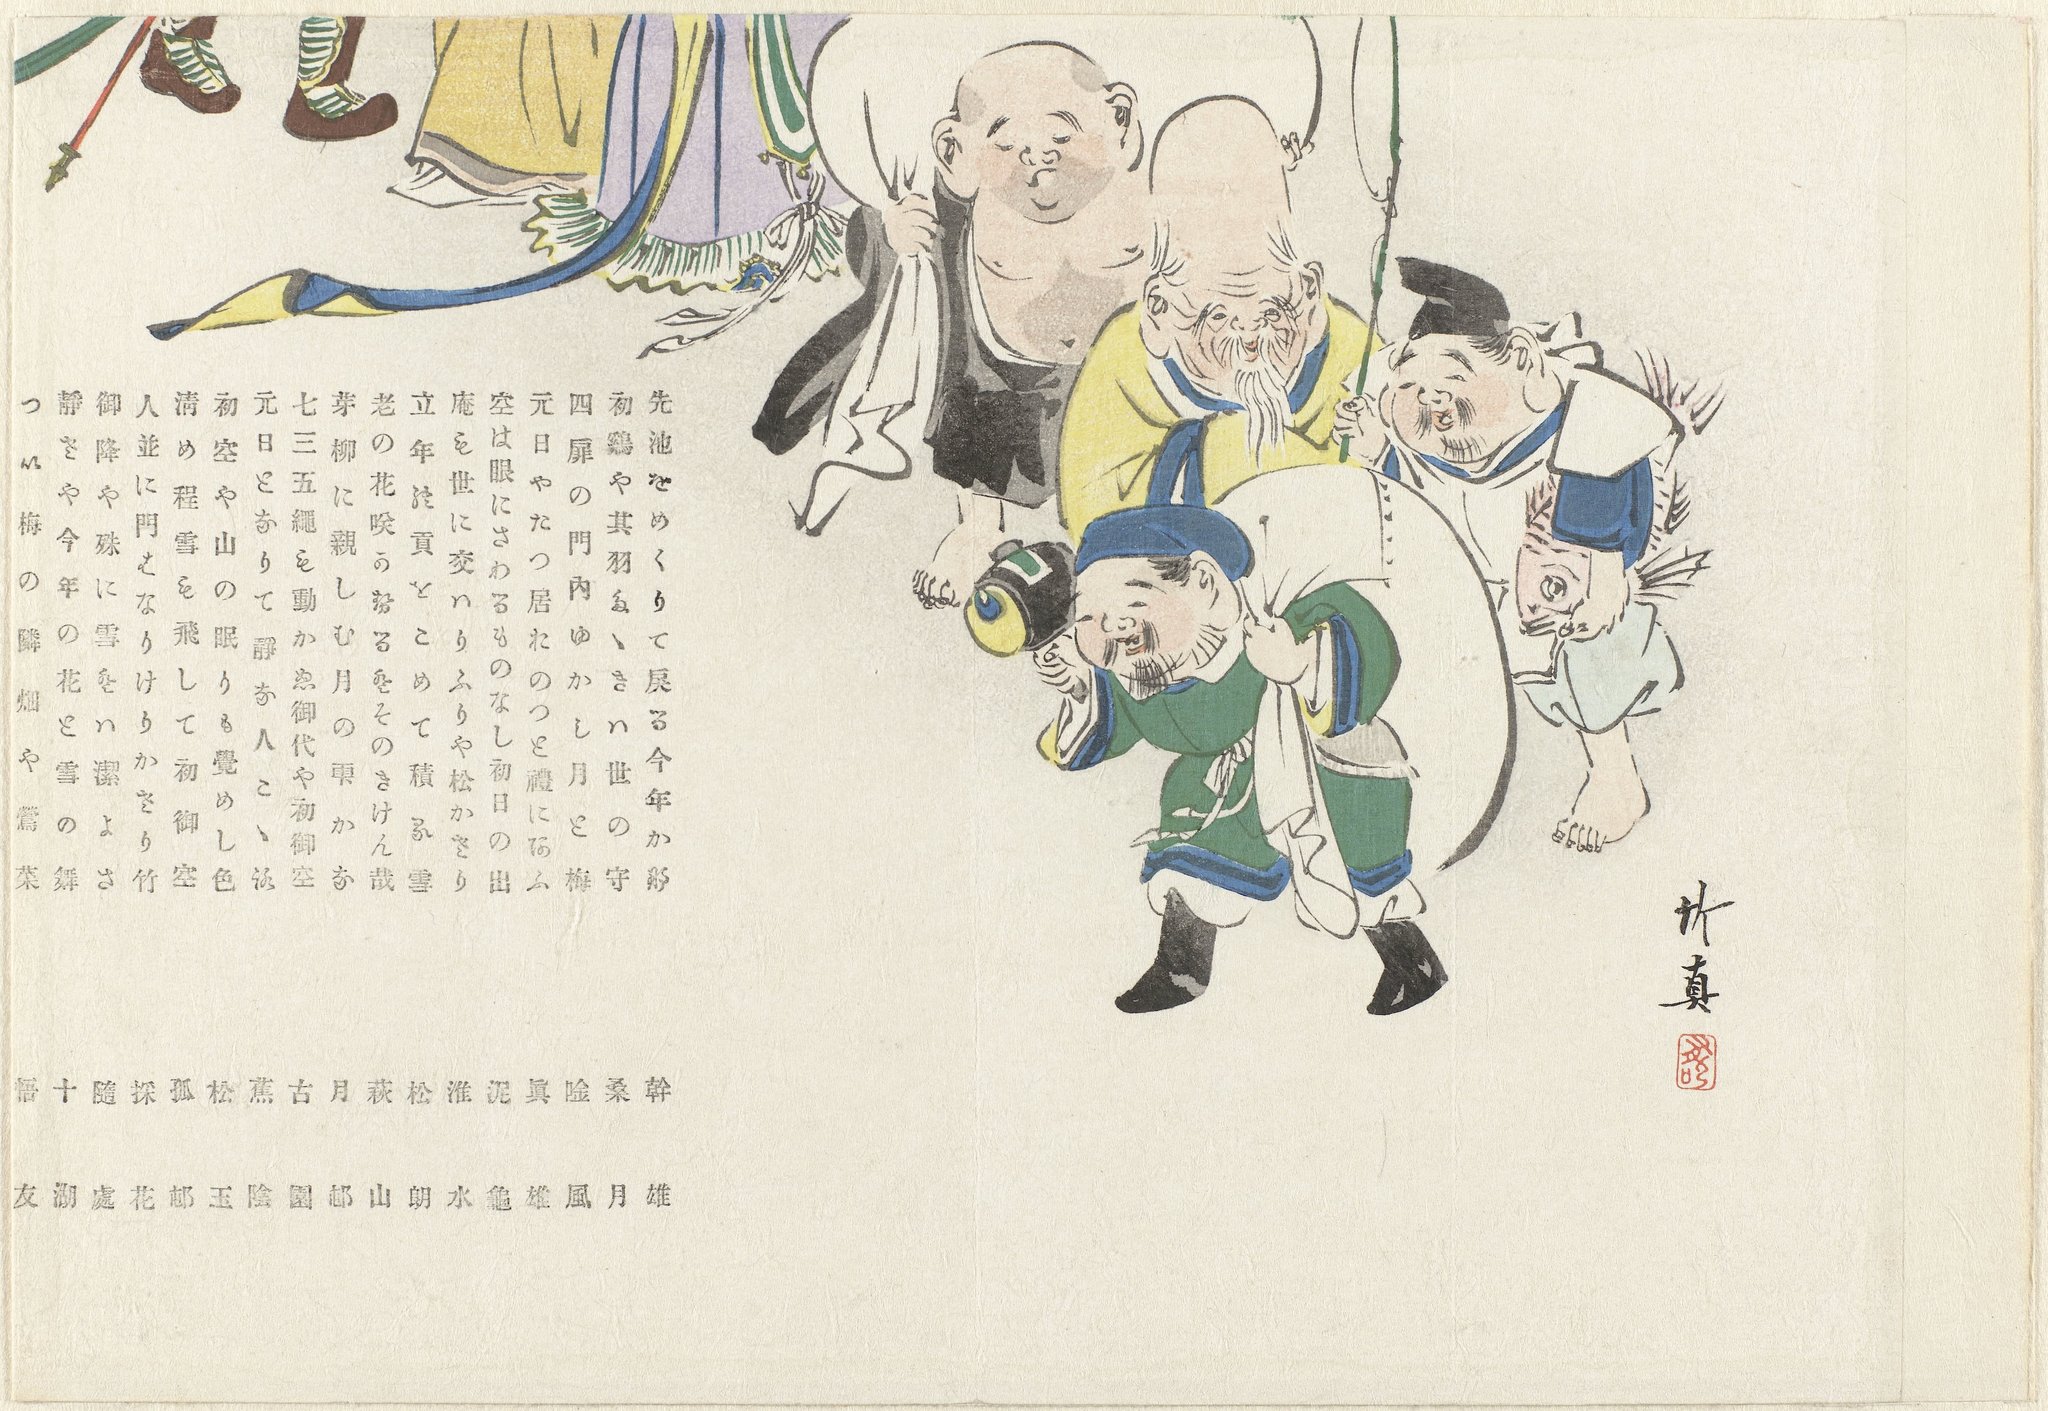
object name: print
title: Optocht van de geluksgoden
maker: chikushin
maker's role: print maker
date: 1899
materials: paper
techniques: woodcut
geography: japan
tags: shinto, oriental ideographic script (chinese, korean, japanese)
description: Een surimono is een luxe uitgevoerde prent waarop beeld met één of meerdere gedichten gecombineerd is. Bij het drukken van een surimono werd vaak gebruik gemaakt van dikker papier, blinddruk en metaal pigmenten, zoals koper- en zilverpoeder. De prenten werden vaak in opdracht van dichters gemaakt en als exclusief geschenk aan vrienden en relaties gegeven.